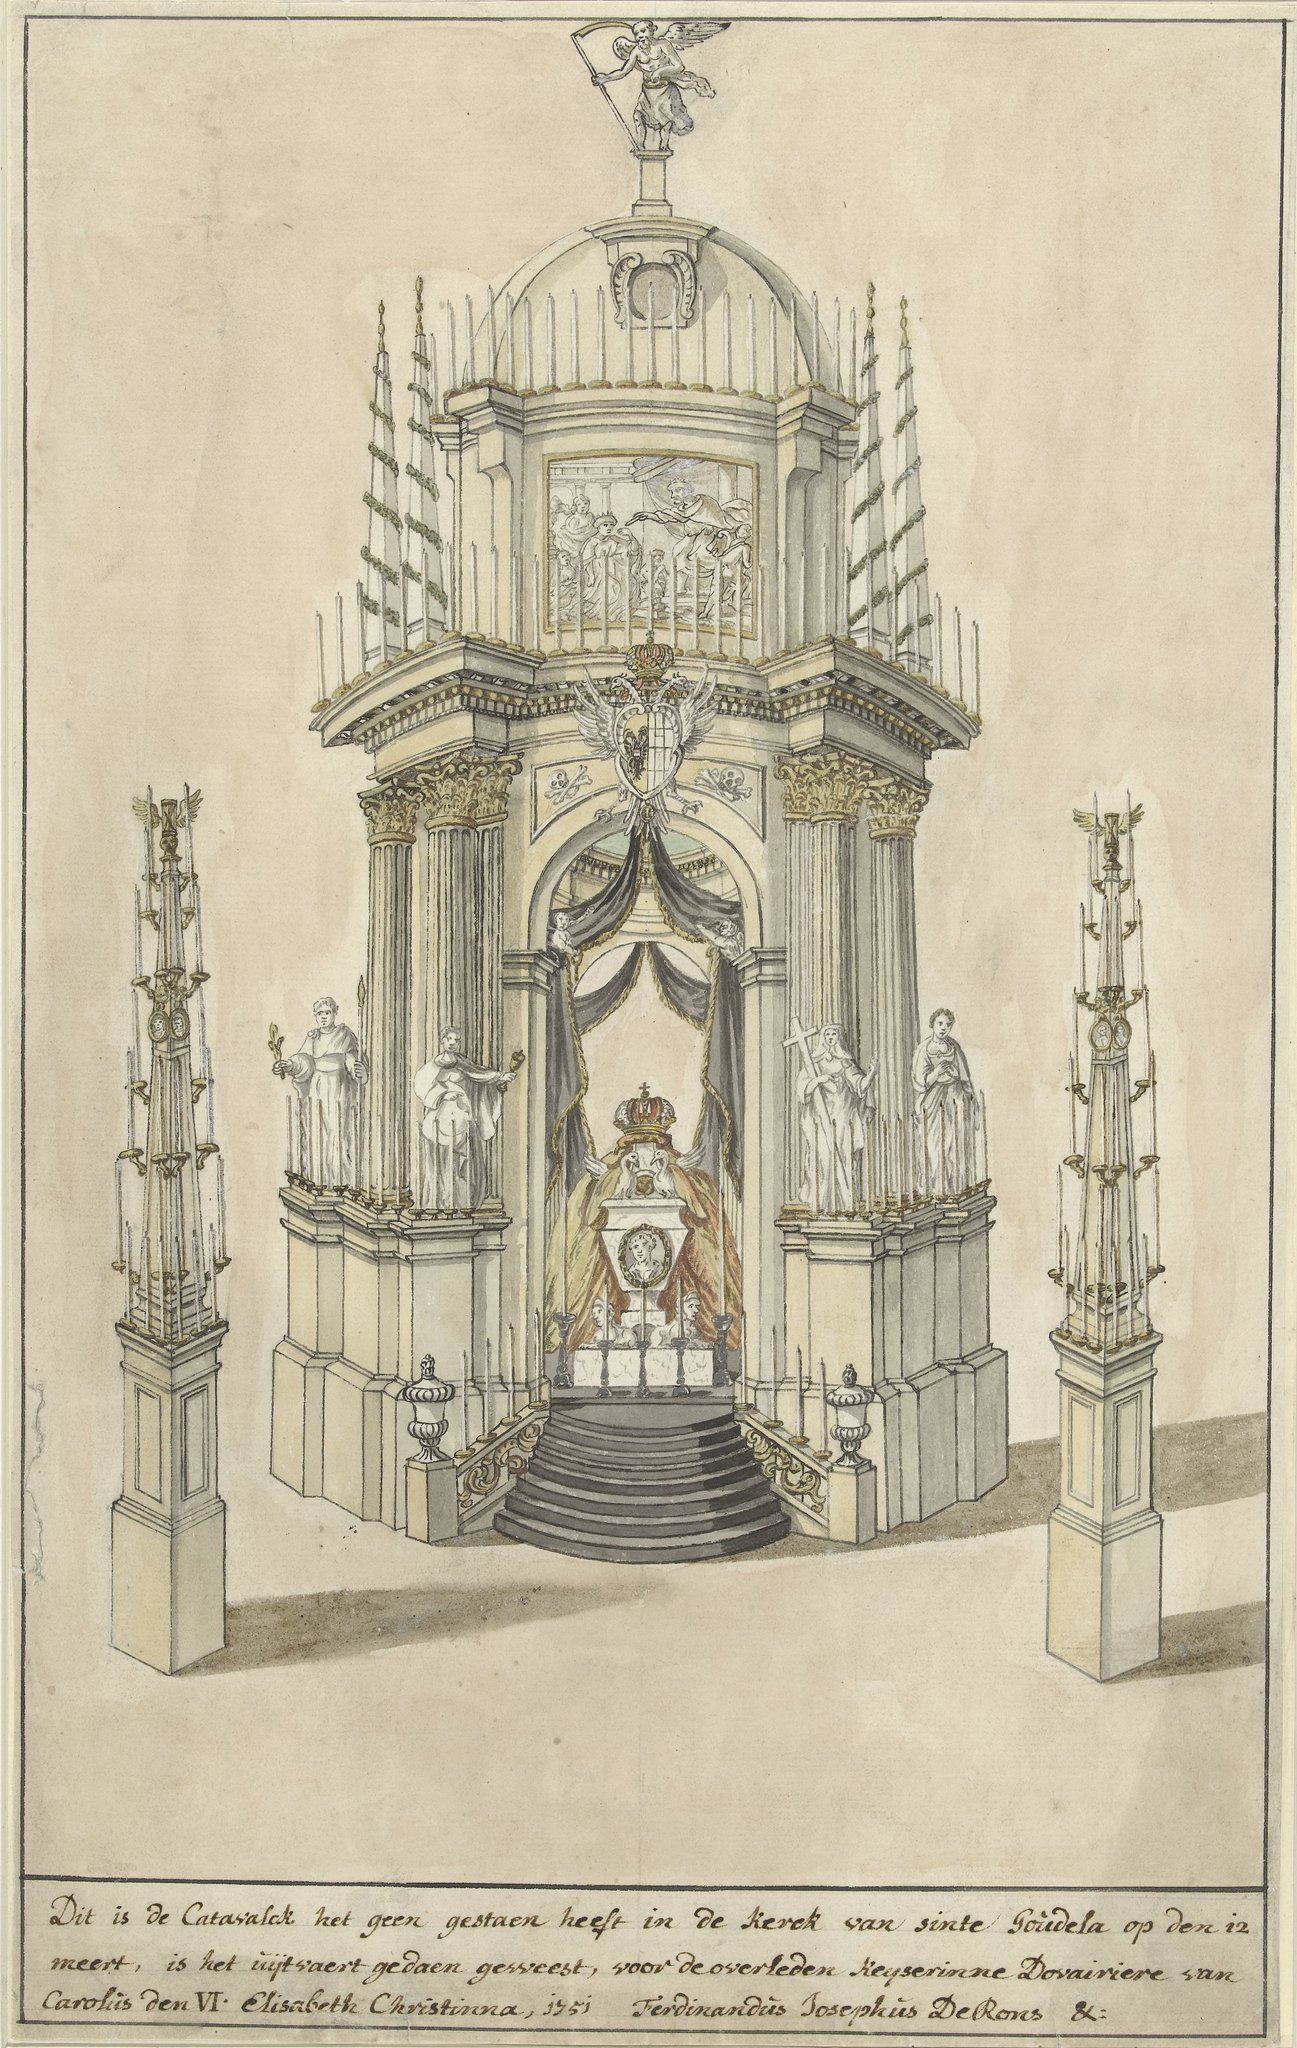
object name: drawing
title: Katafalk voor keizerin Elisabeth Christine te Brussel, 1751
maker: ferdinandus josephus de rons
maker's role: draughtsman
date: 1751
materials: paper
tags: catafalque, 'castrum doloris' (~ public funeral)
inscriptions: inscription: ‘Dit is de Catavalck het geen gestaen heeft in de kerck van sinte Goudela op den 12 meert, is het uijtvaert gedaen geweest, voor de overleden Keyserinne Douairiere van Carolus den VI. Elisabeth Christinna, 1751.’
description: De katafalk voor Elisabeth Christine, keizerin van Oostenrijk, weduwe van keizer Karel VI, opgesteld in de St. Goedele kerk te Brussel bij de uitvaart op 12 maart 1751.